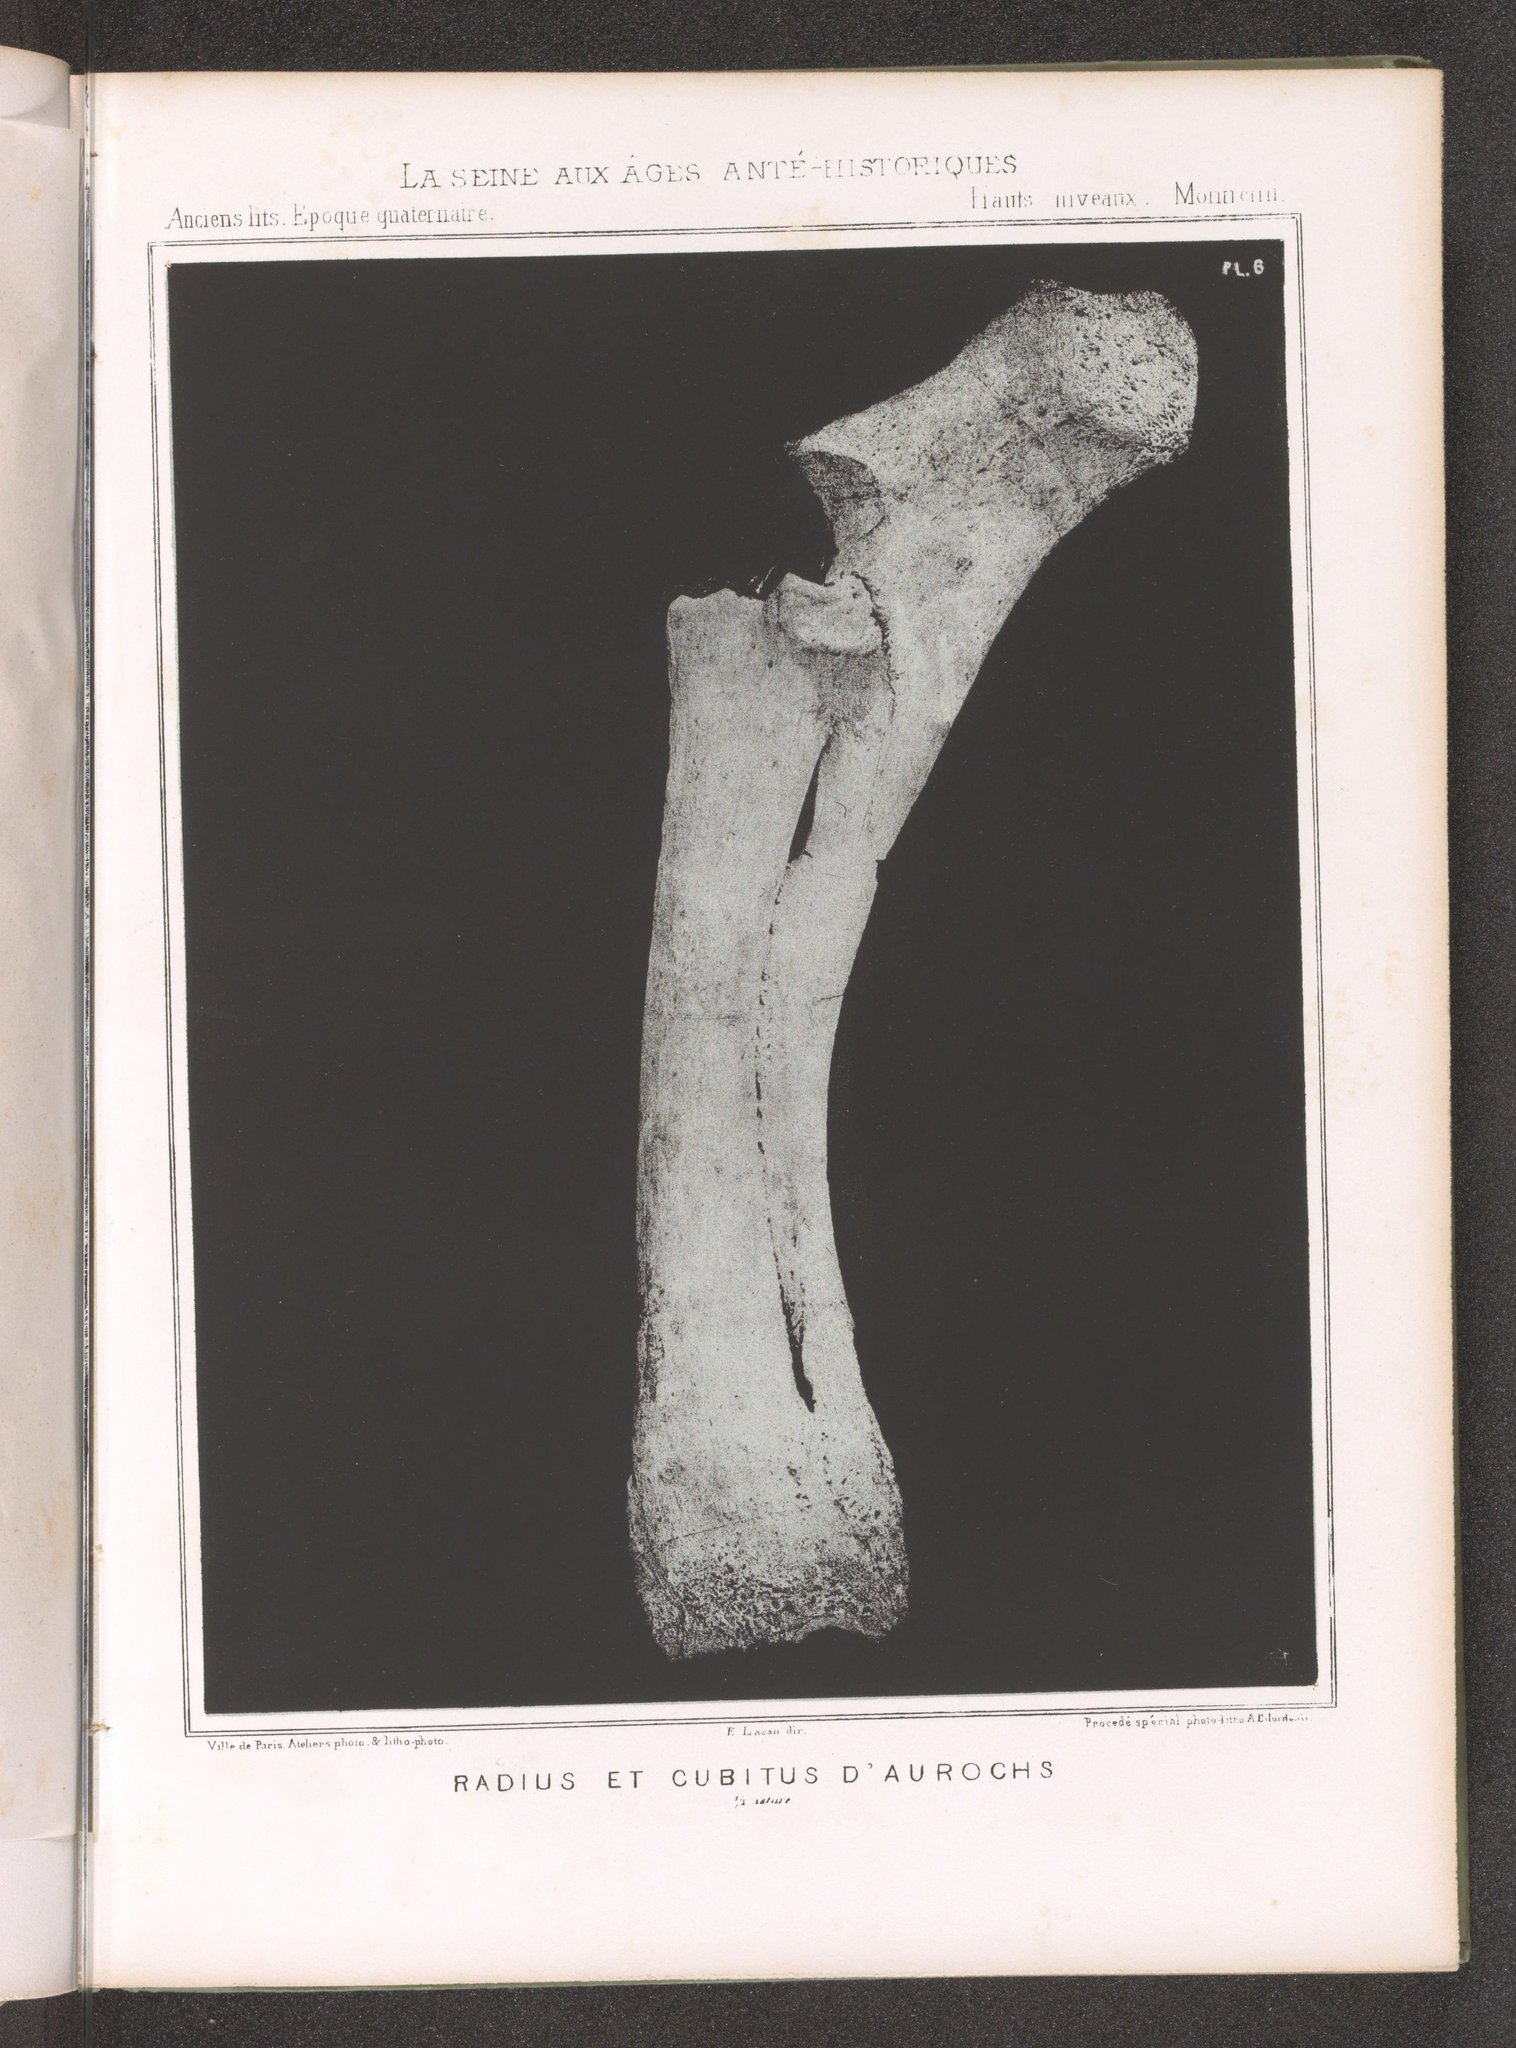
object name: photomechanical print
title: RADIUS ET CUBITUS D'AUROCHS 1/2 nature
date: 1860-1869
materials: paper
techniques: photolithography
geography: paris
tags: animals (+ skeleton of an animal), palaeontology, france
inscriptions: number: ‘Pl. 6’, inscription: ‘Ville de Paris Ateliers photo & litho photo E. Lacan, dir. Procédé spécial photo-litho A. Bilordeaux’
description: Voor plek prent in boek: zie nummer onder 'Opschriften / Merken'.